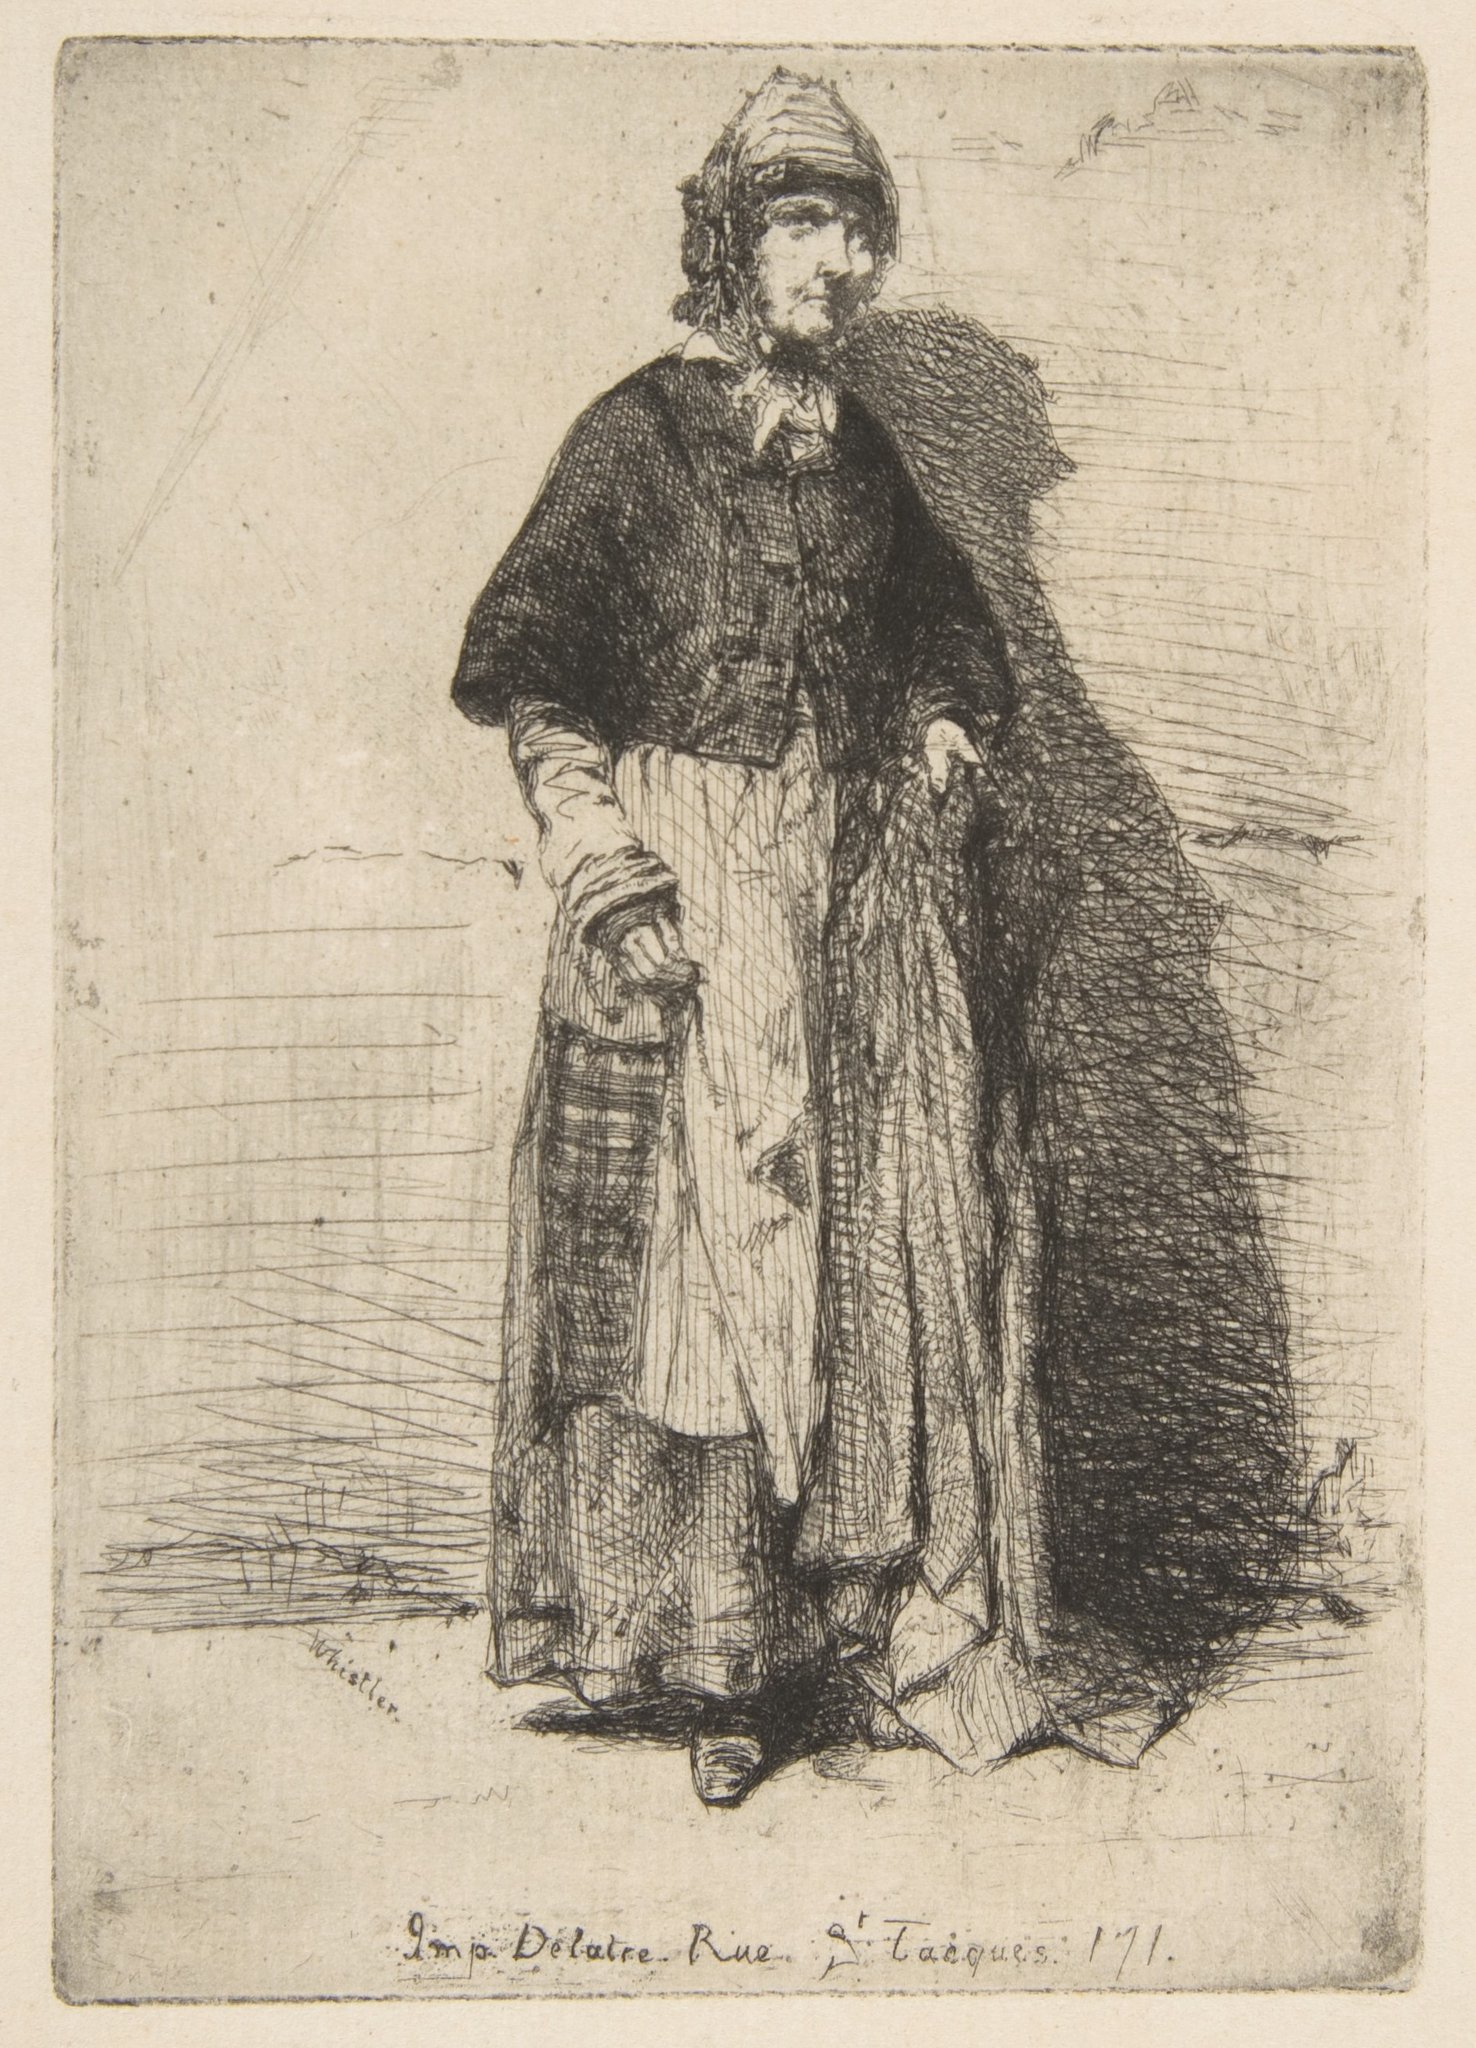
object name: print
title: La Mère Gérard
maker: james mcneill whistler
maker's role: artist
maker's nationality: american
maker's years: 1834-1903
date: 1858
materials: ink, paper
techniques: etching, printing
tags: women